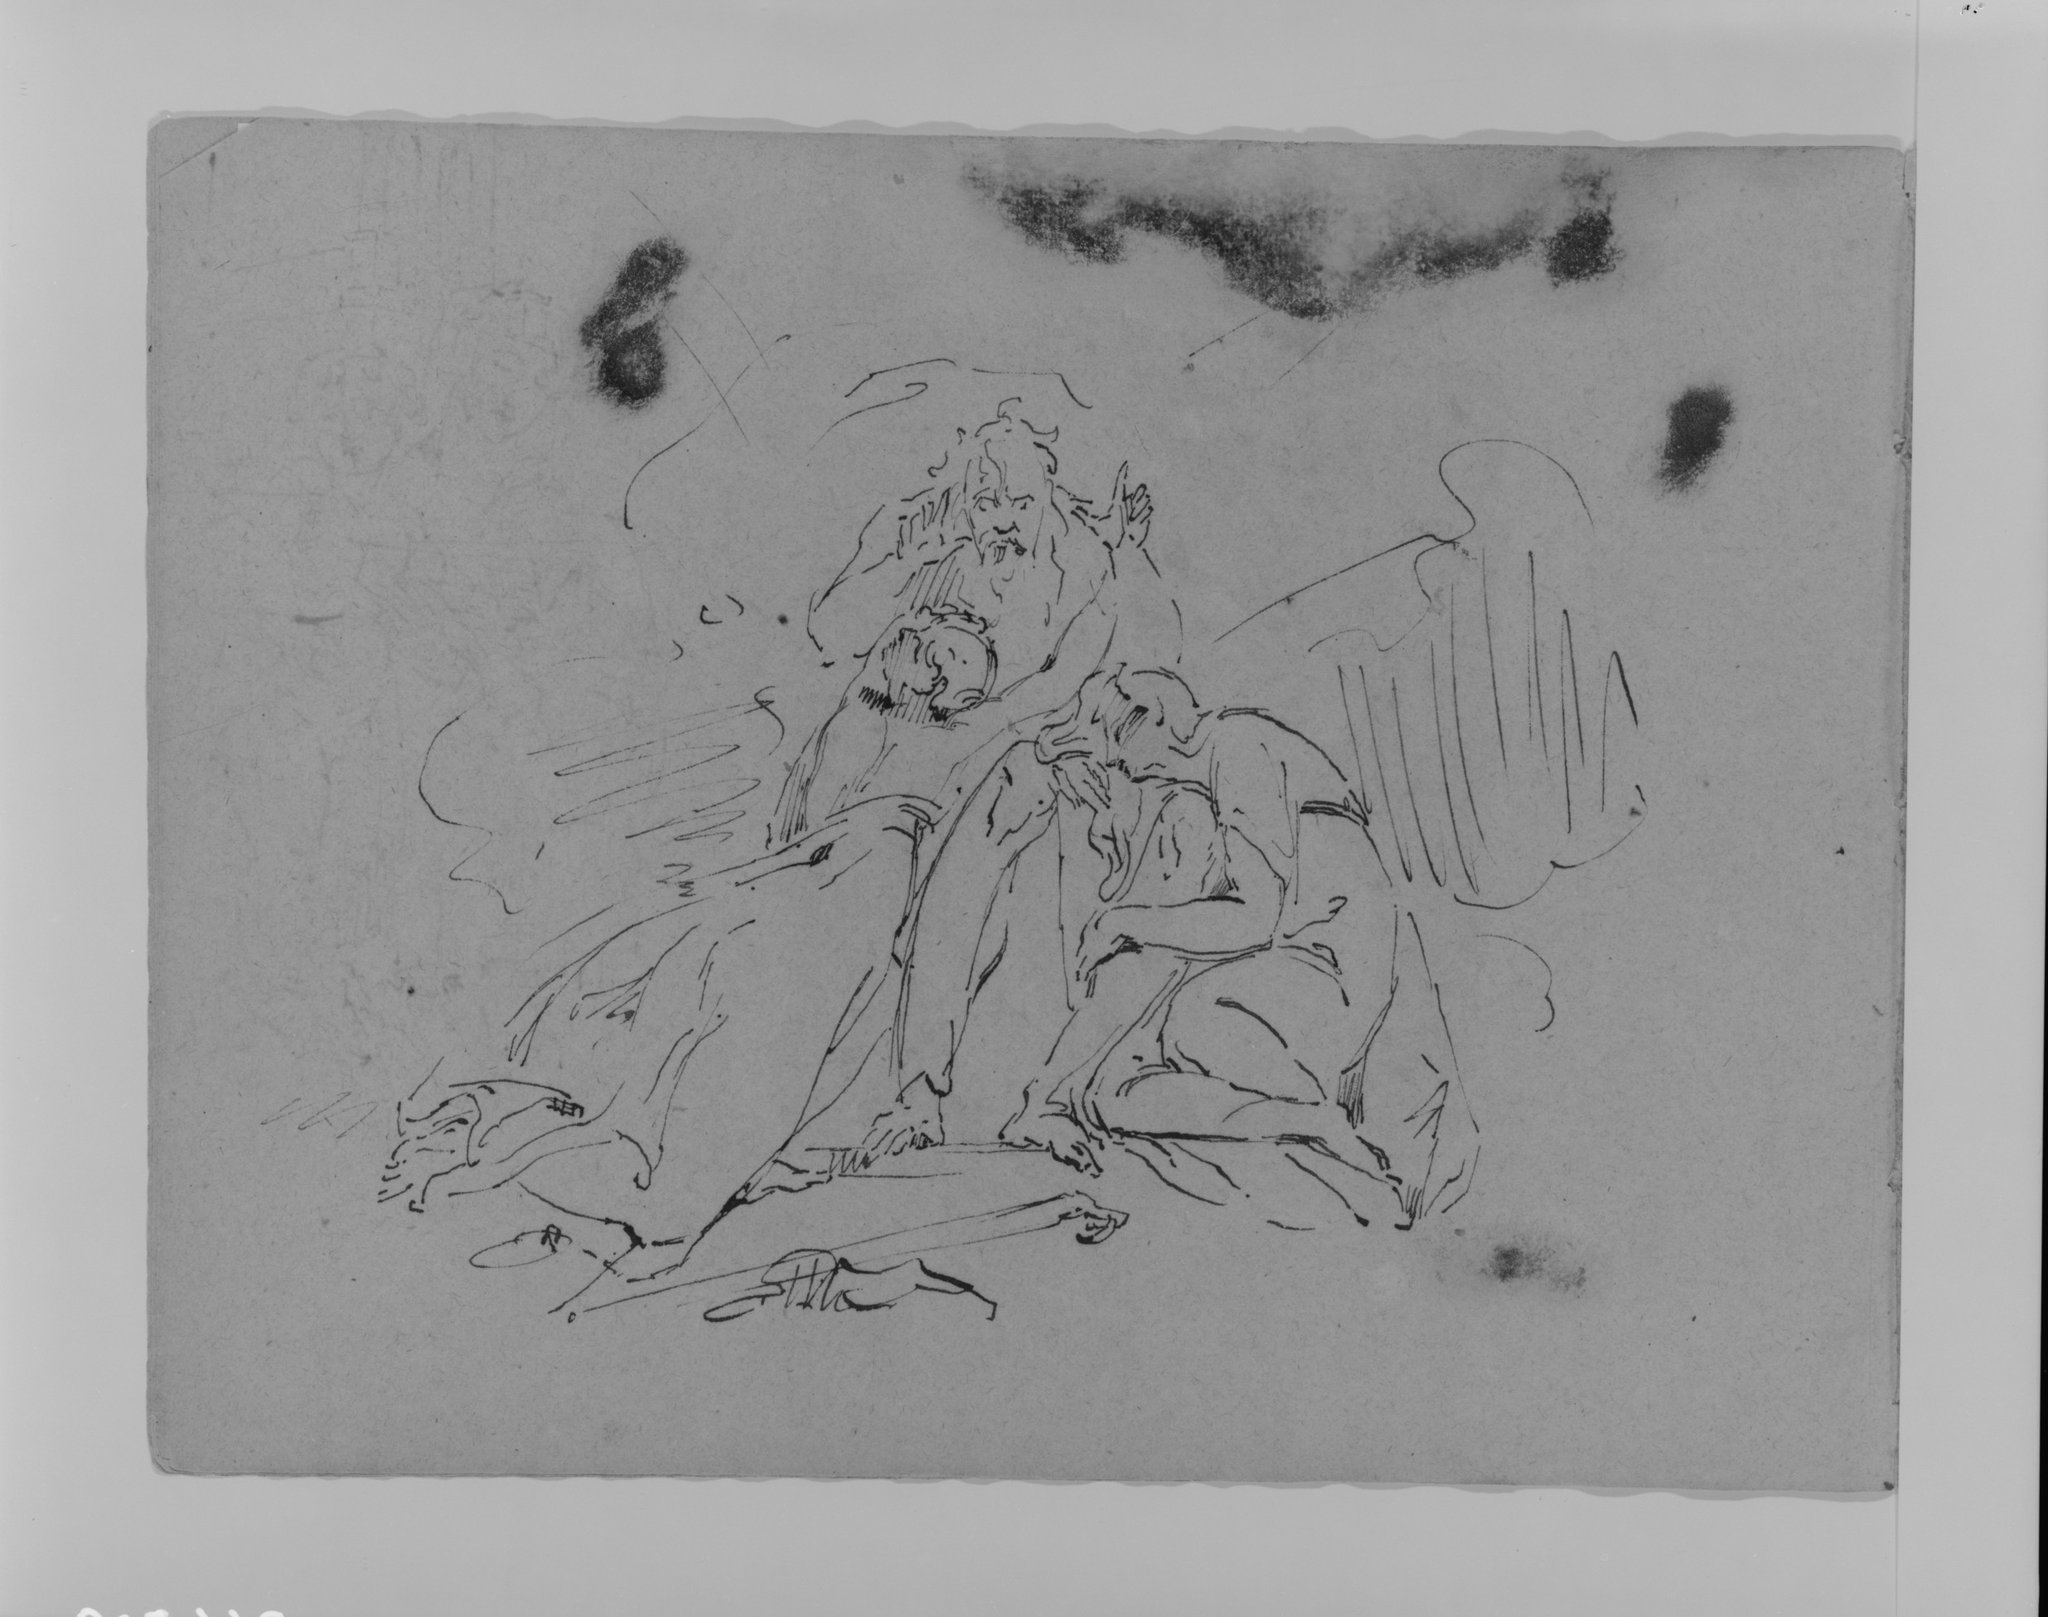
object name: drawing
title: (From Sketchbook)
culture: american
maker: thomas sully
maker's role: artist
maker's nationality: american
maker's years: 1783-1872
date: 1810-1820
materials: ink, paper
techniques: wash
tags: men